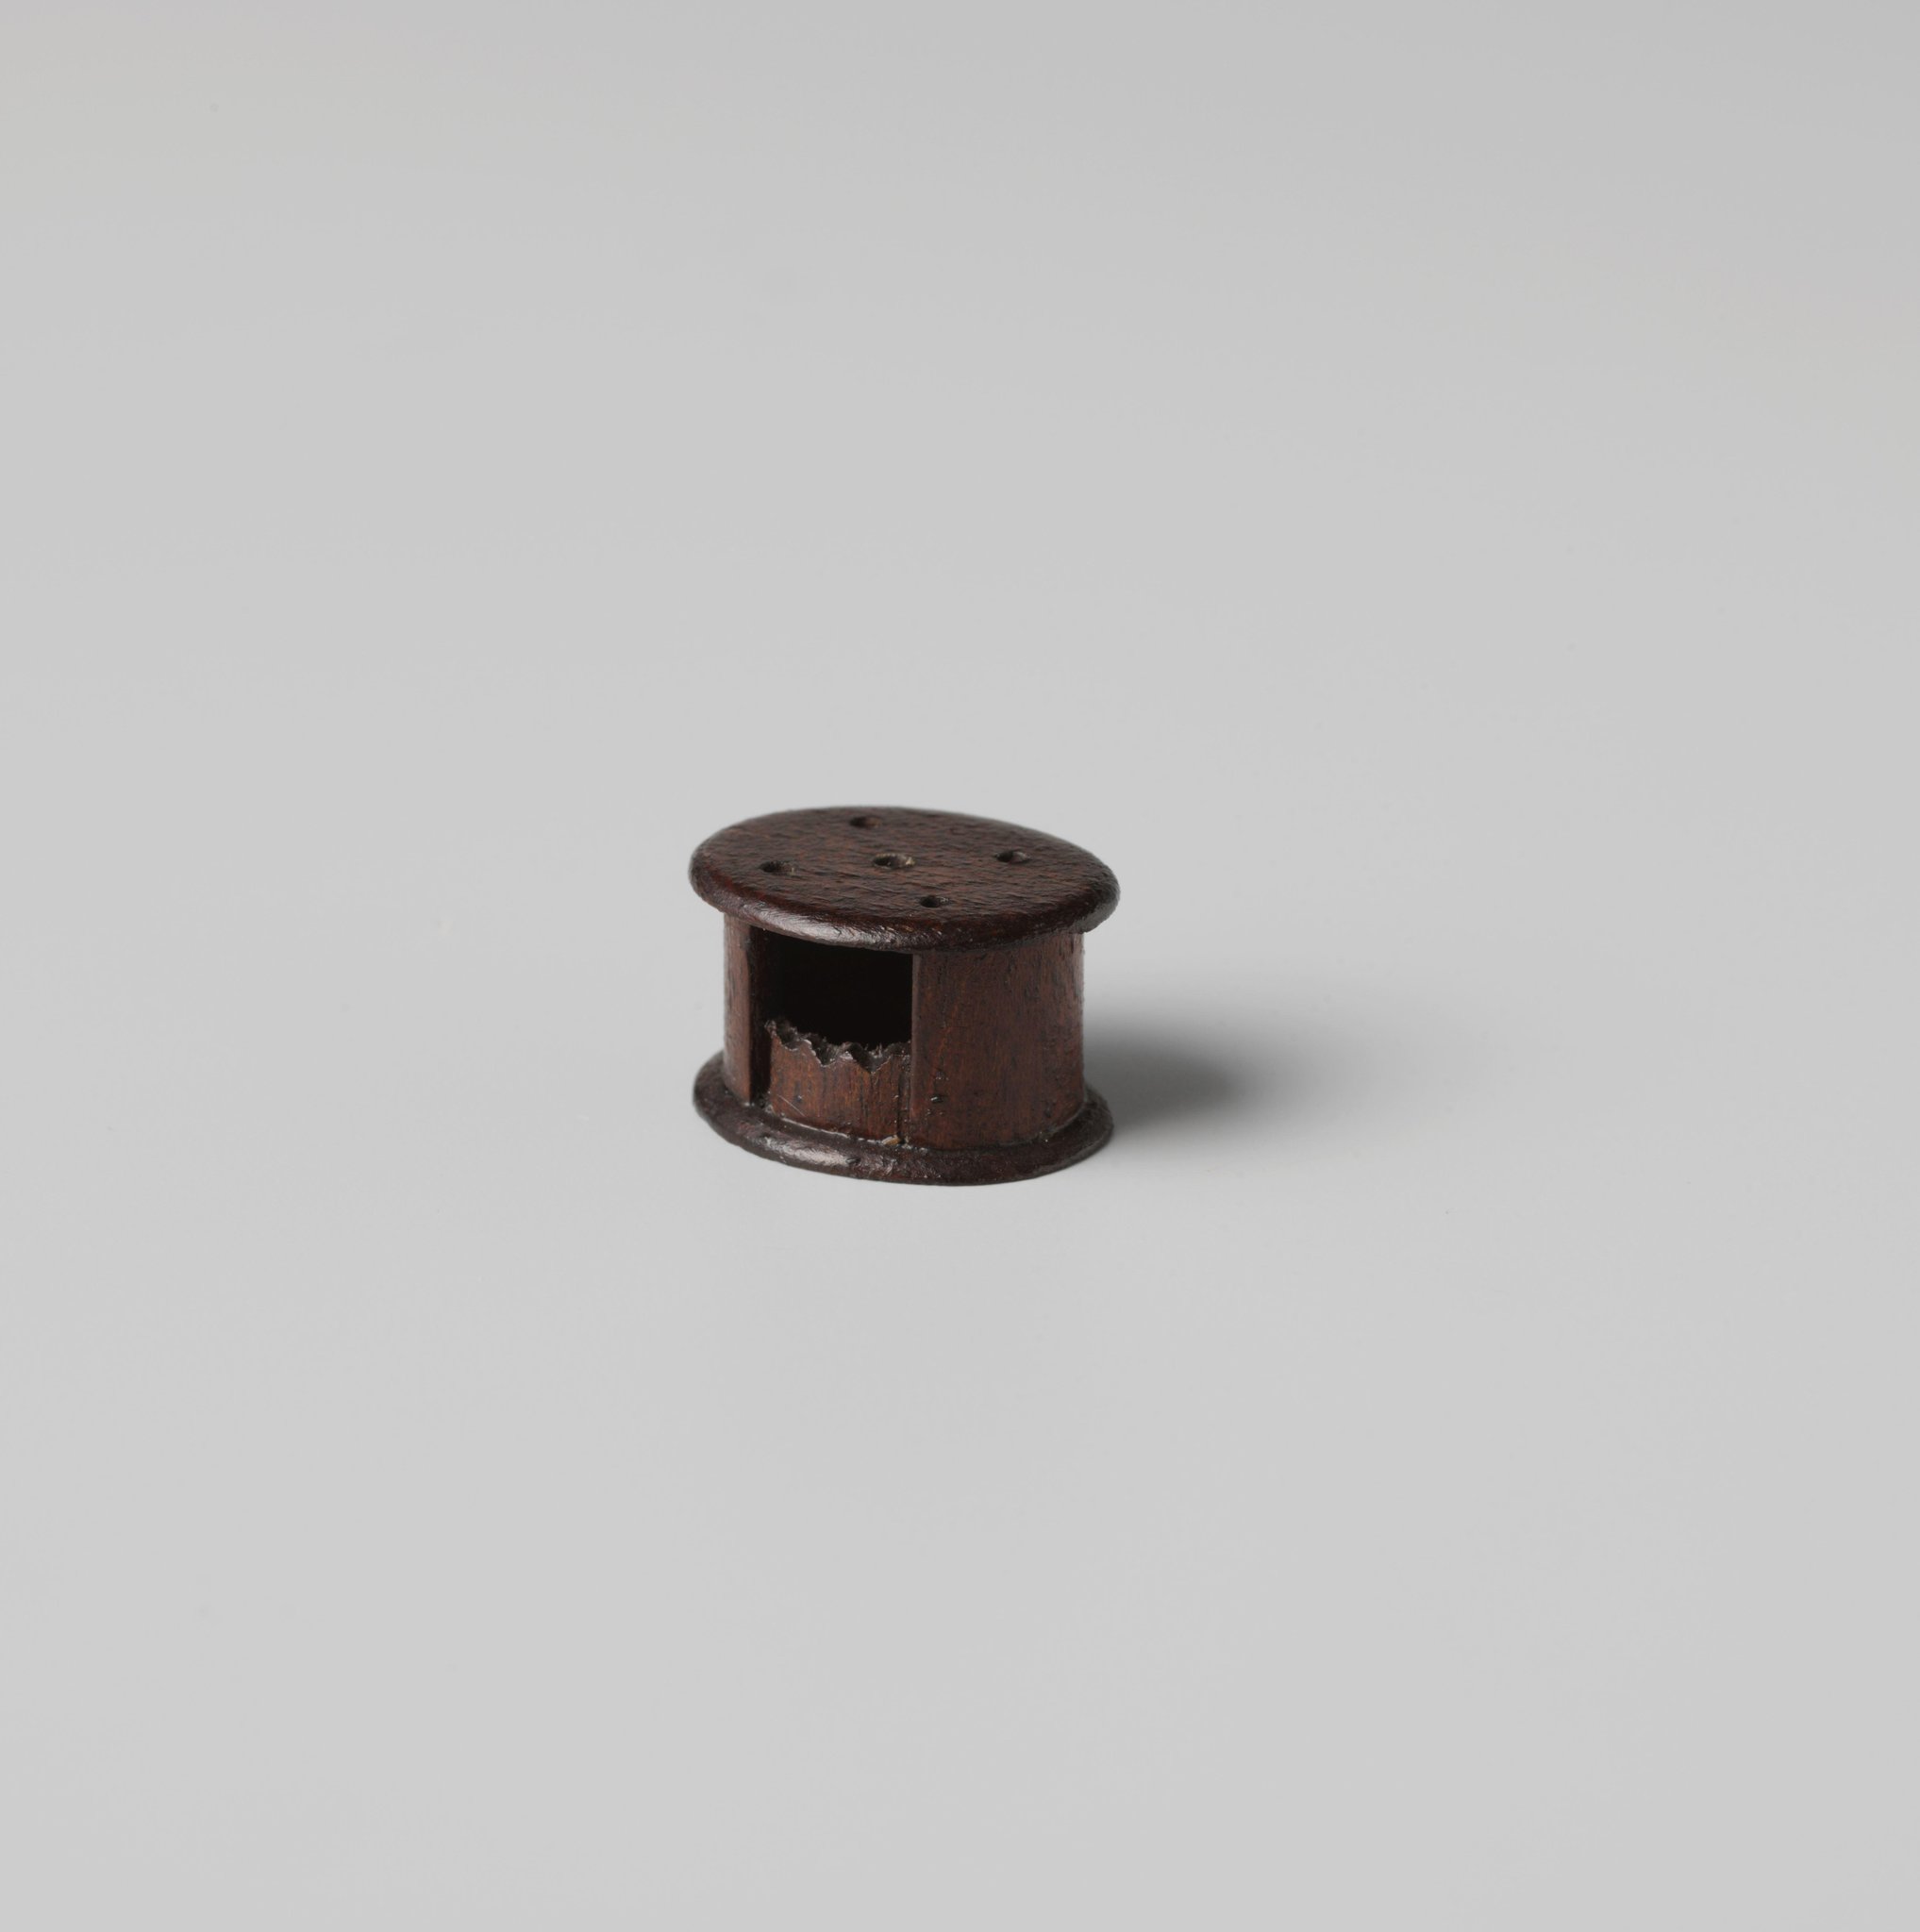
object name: miniature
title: Stoof, ovaal, met vijf gaten in de bovenzijde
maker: Anonymous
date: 1740-1760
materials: wood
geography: amsterdam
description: Stoof van mahoniehout, ovaal met in de bovenzijde vijf gaten, de opening voor de vuurtest is afgewerkt met een geschulpte voorregel.